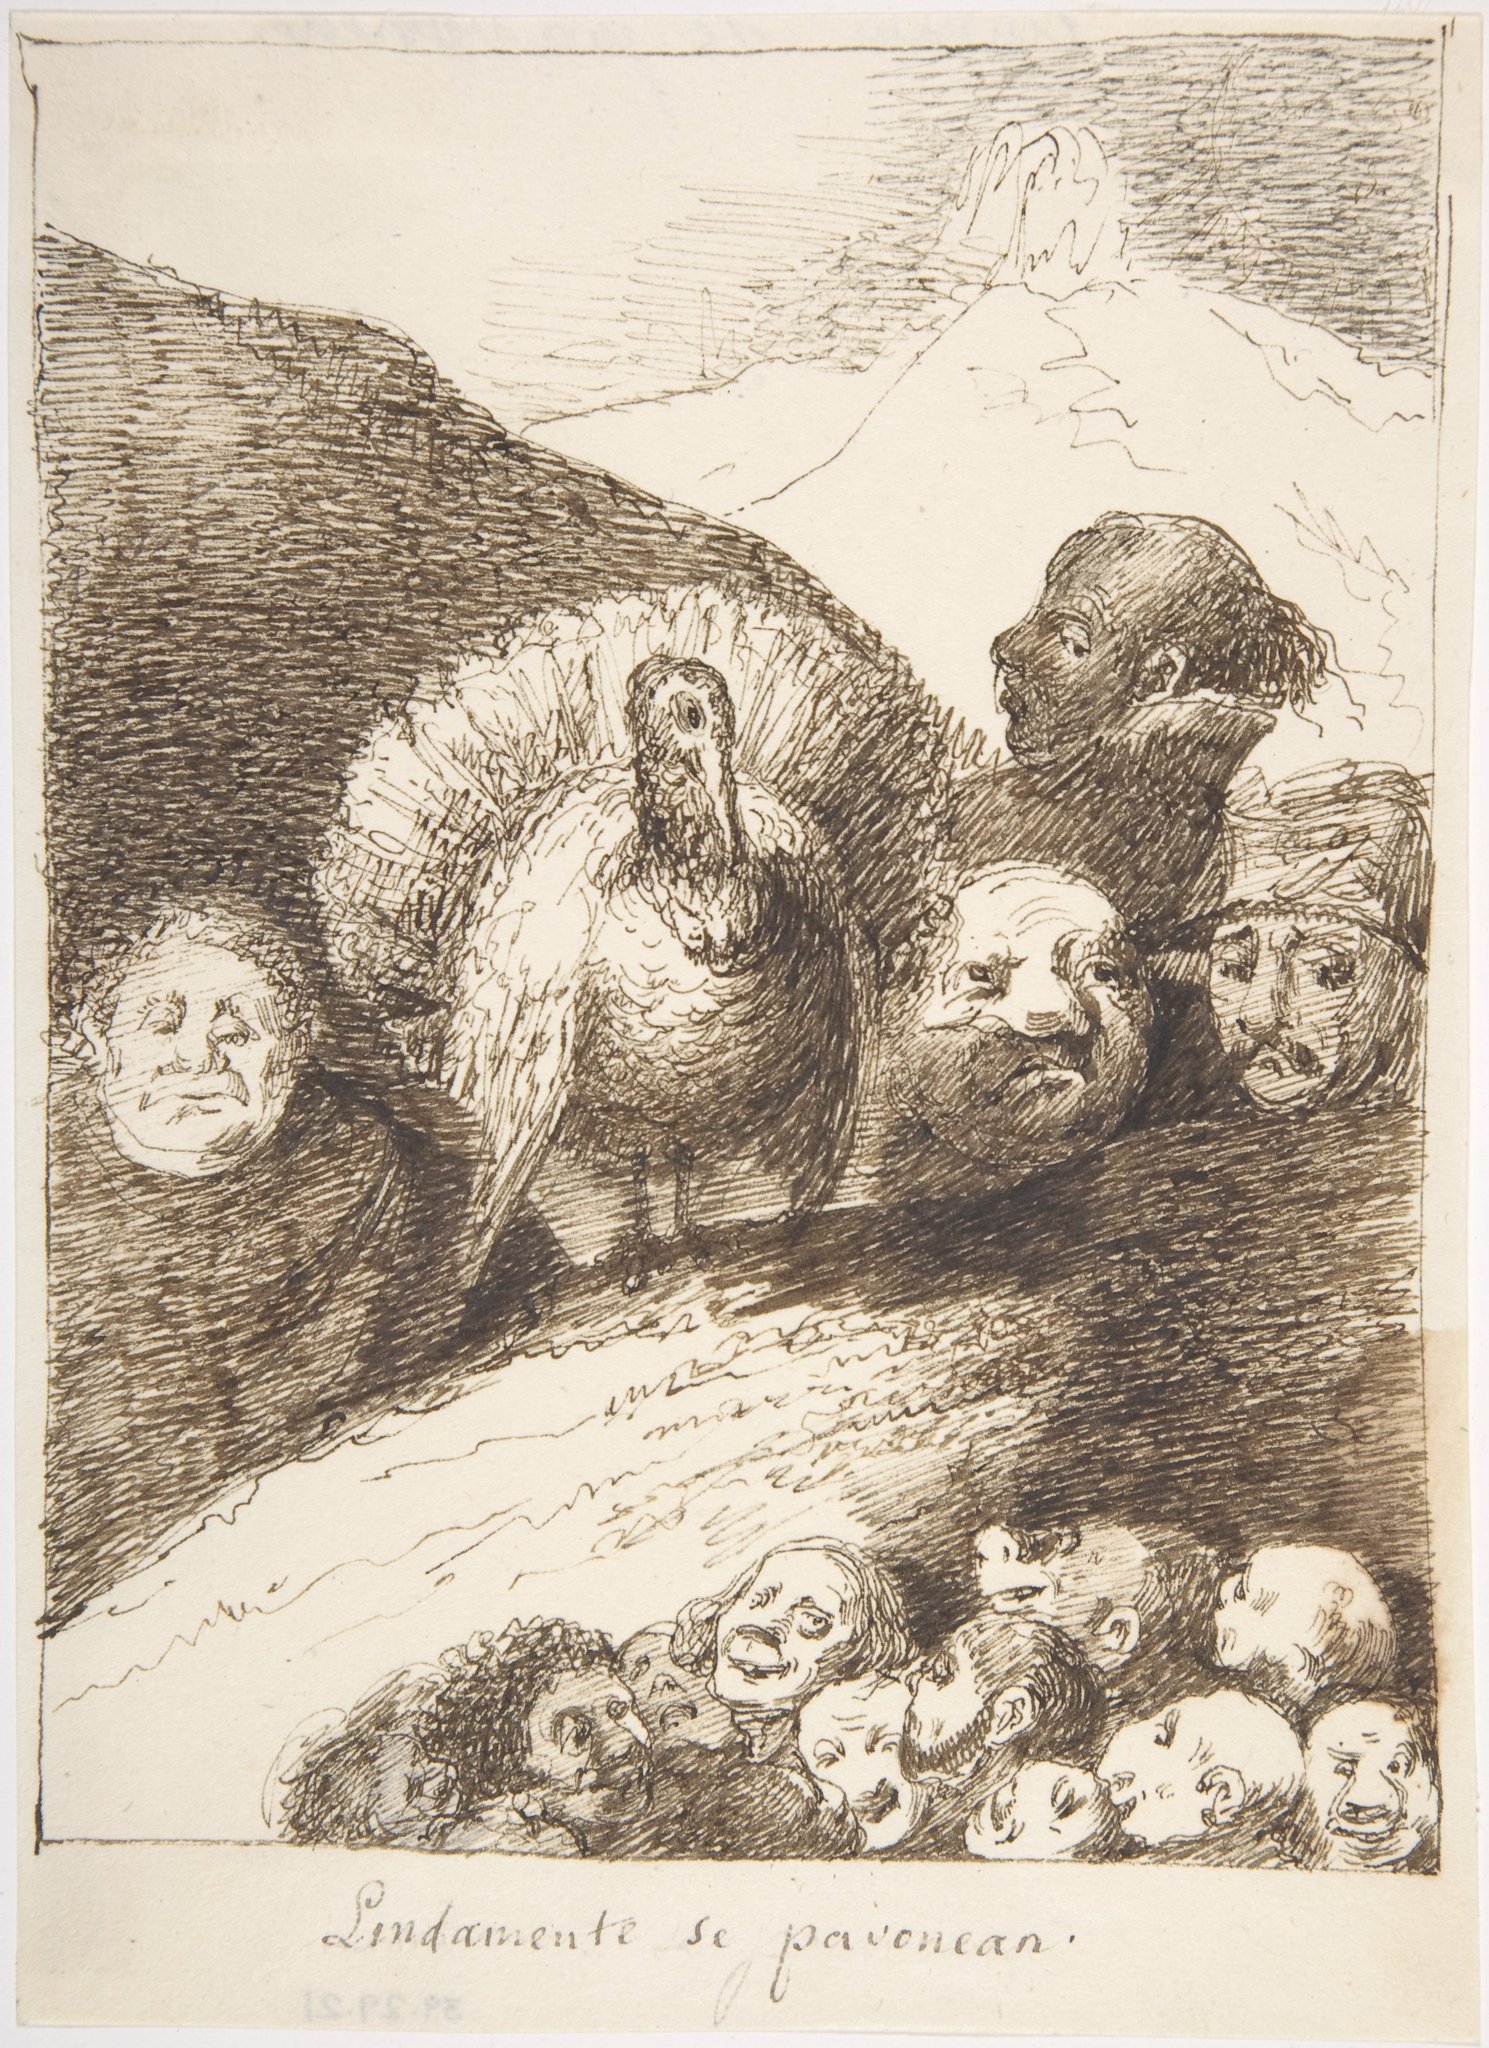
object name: drawing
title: They Strut About Elegantly (Lindamente se pavonean)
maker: leonardo alenza y nieto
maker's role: artist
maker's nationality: spanish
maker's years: 1807-1845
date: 1807-1845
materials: graphite, ink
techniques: brush, pen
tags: men,turkeys